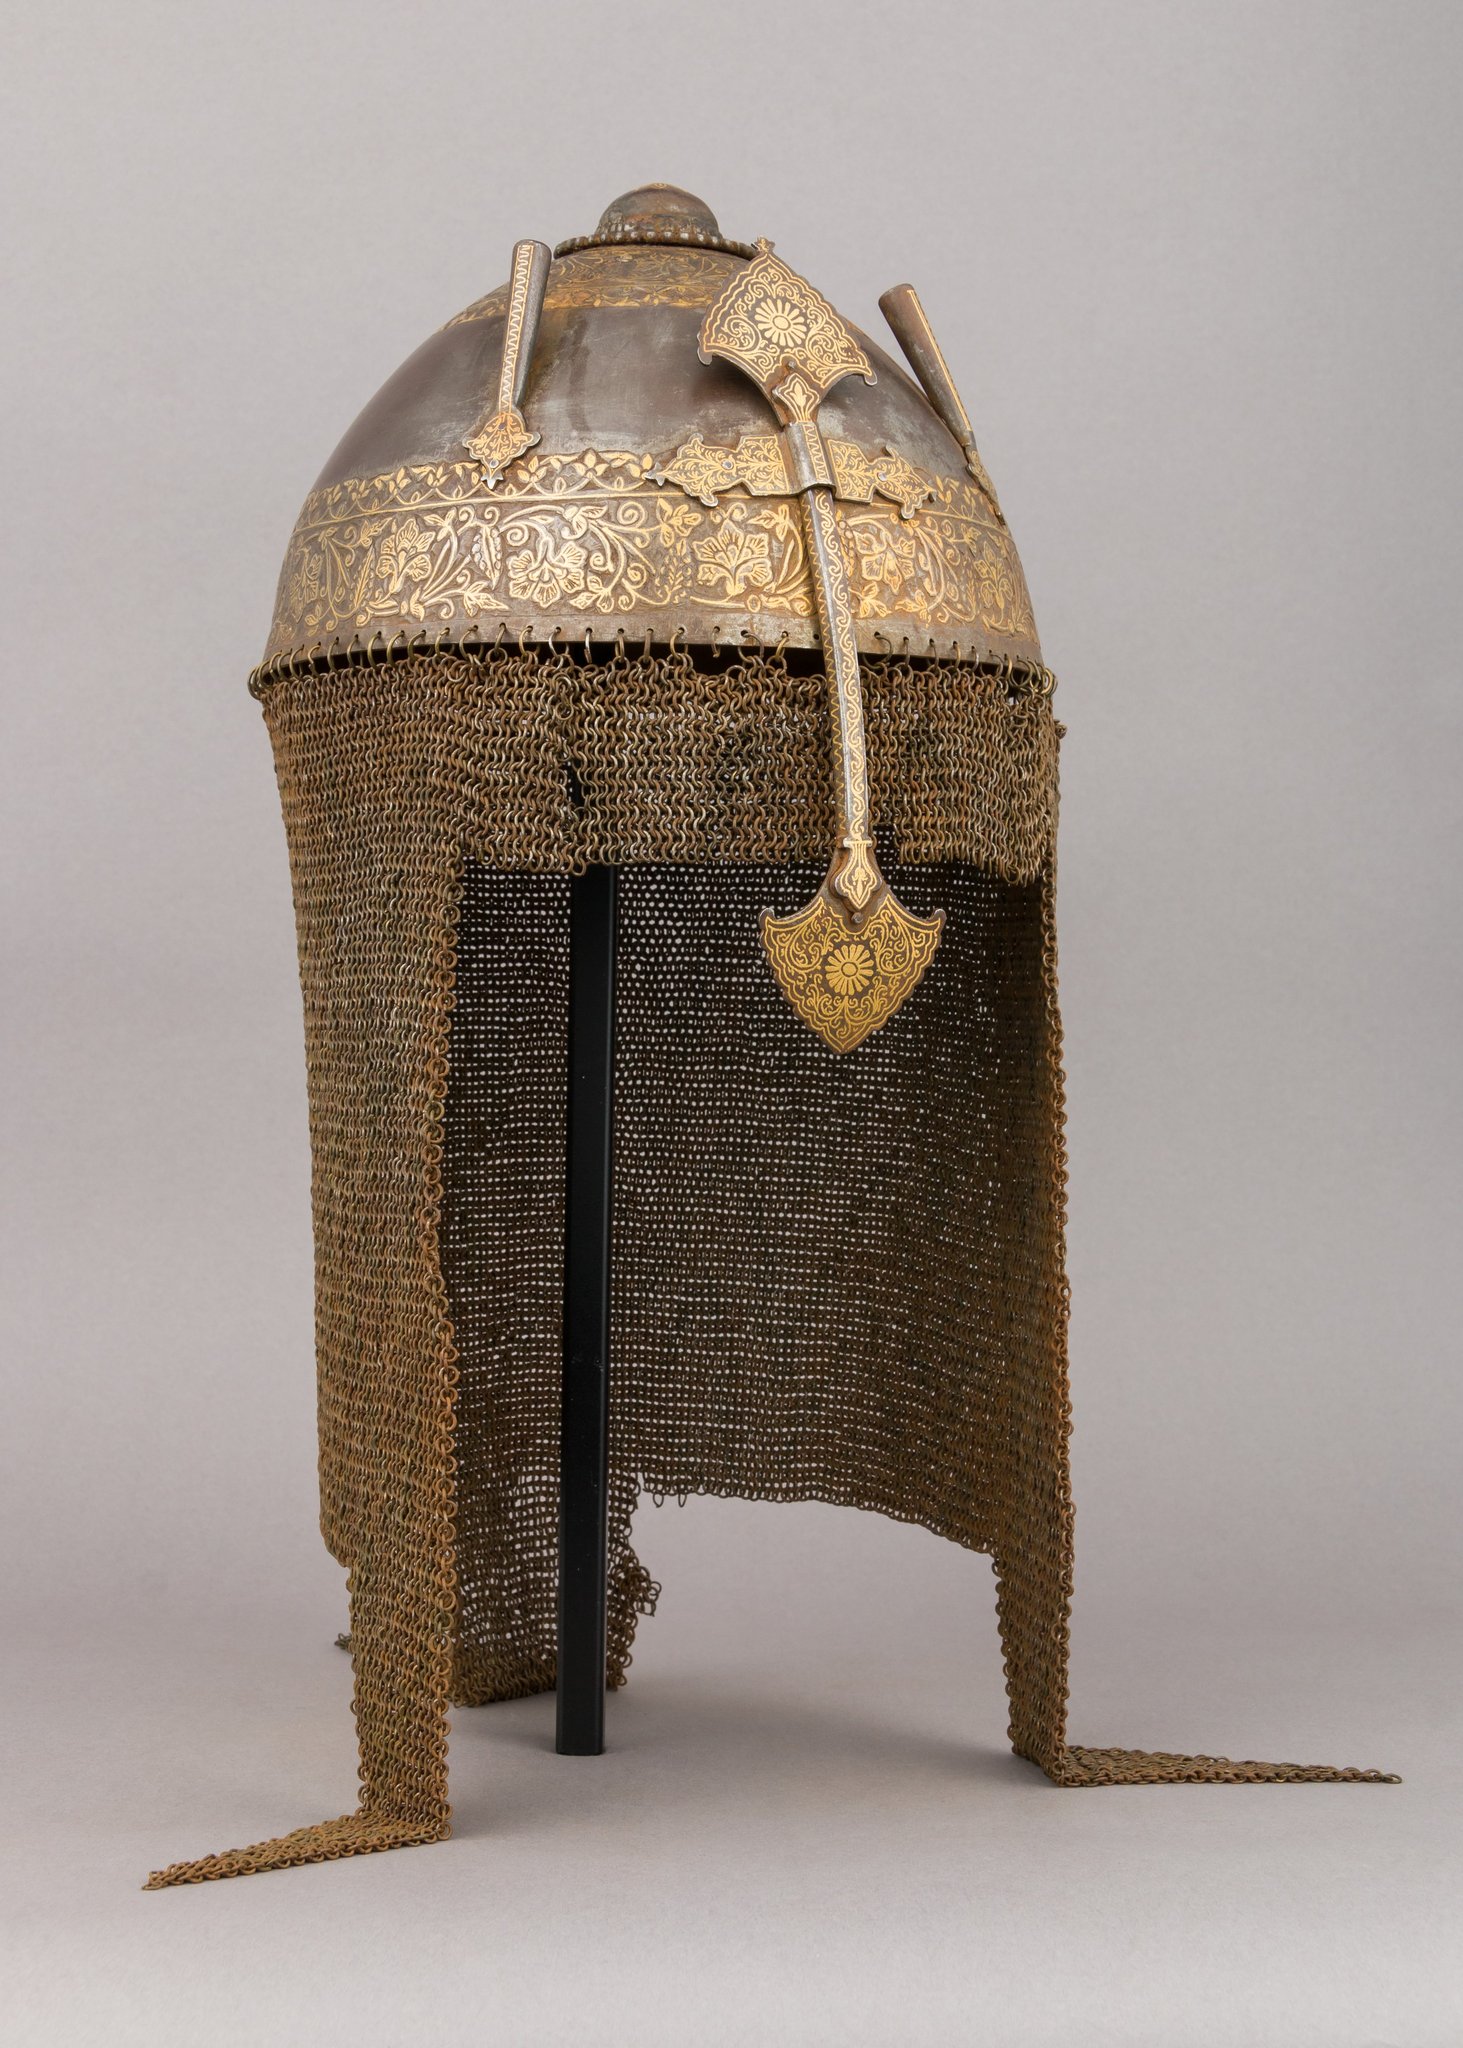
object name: helmet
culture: indian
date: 1701-1900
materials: brass, gold, steel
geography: india